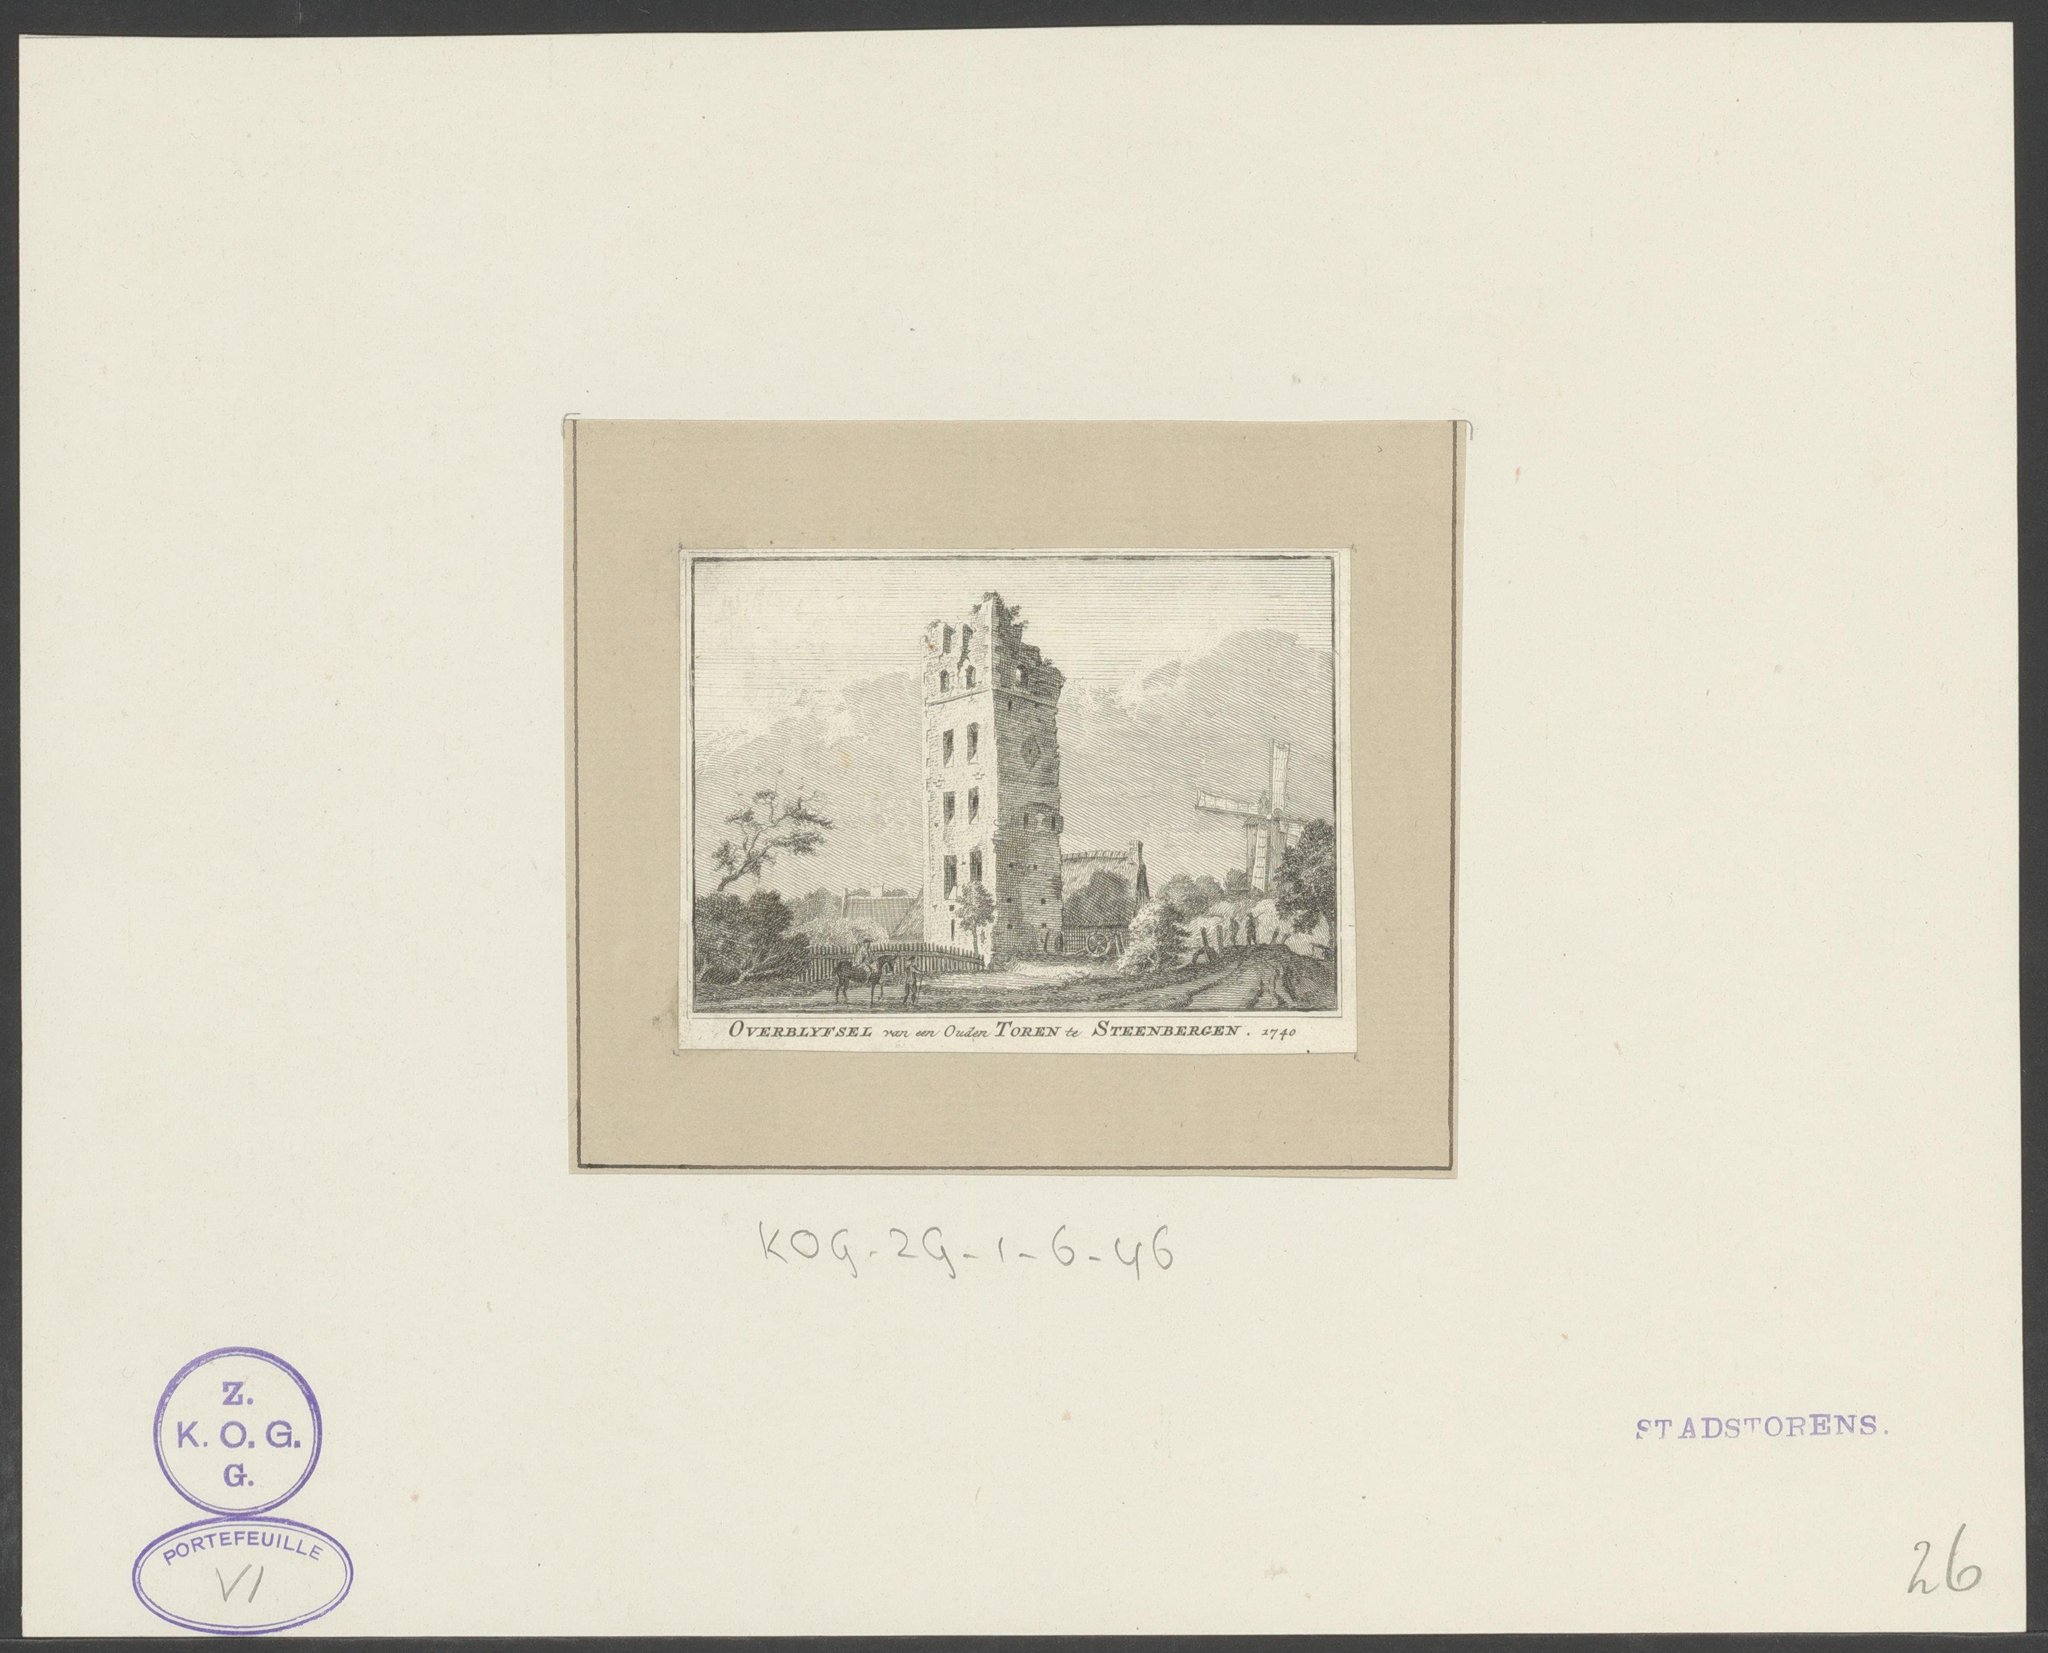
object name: print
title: Overblyfsel van een Ouden Toren te Steenbergen, 1740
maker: Anonymous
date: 1745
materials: paper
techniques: engraving, etching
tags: riding a horse, ass, or mule; rider, horseman, city-view in general; 'veduta', landscape with ruins, windmill, tower (of house or building)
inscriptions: stamp, collector's mark: Lugt 1641, stamp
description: Prent waarschijnlijk uit: Het Verheerlykt Nederland of kabinet van hedendaagsche gezigten (...). Amsterdam: Isaak Tirion, 1745, dl. 1.